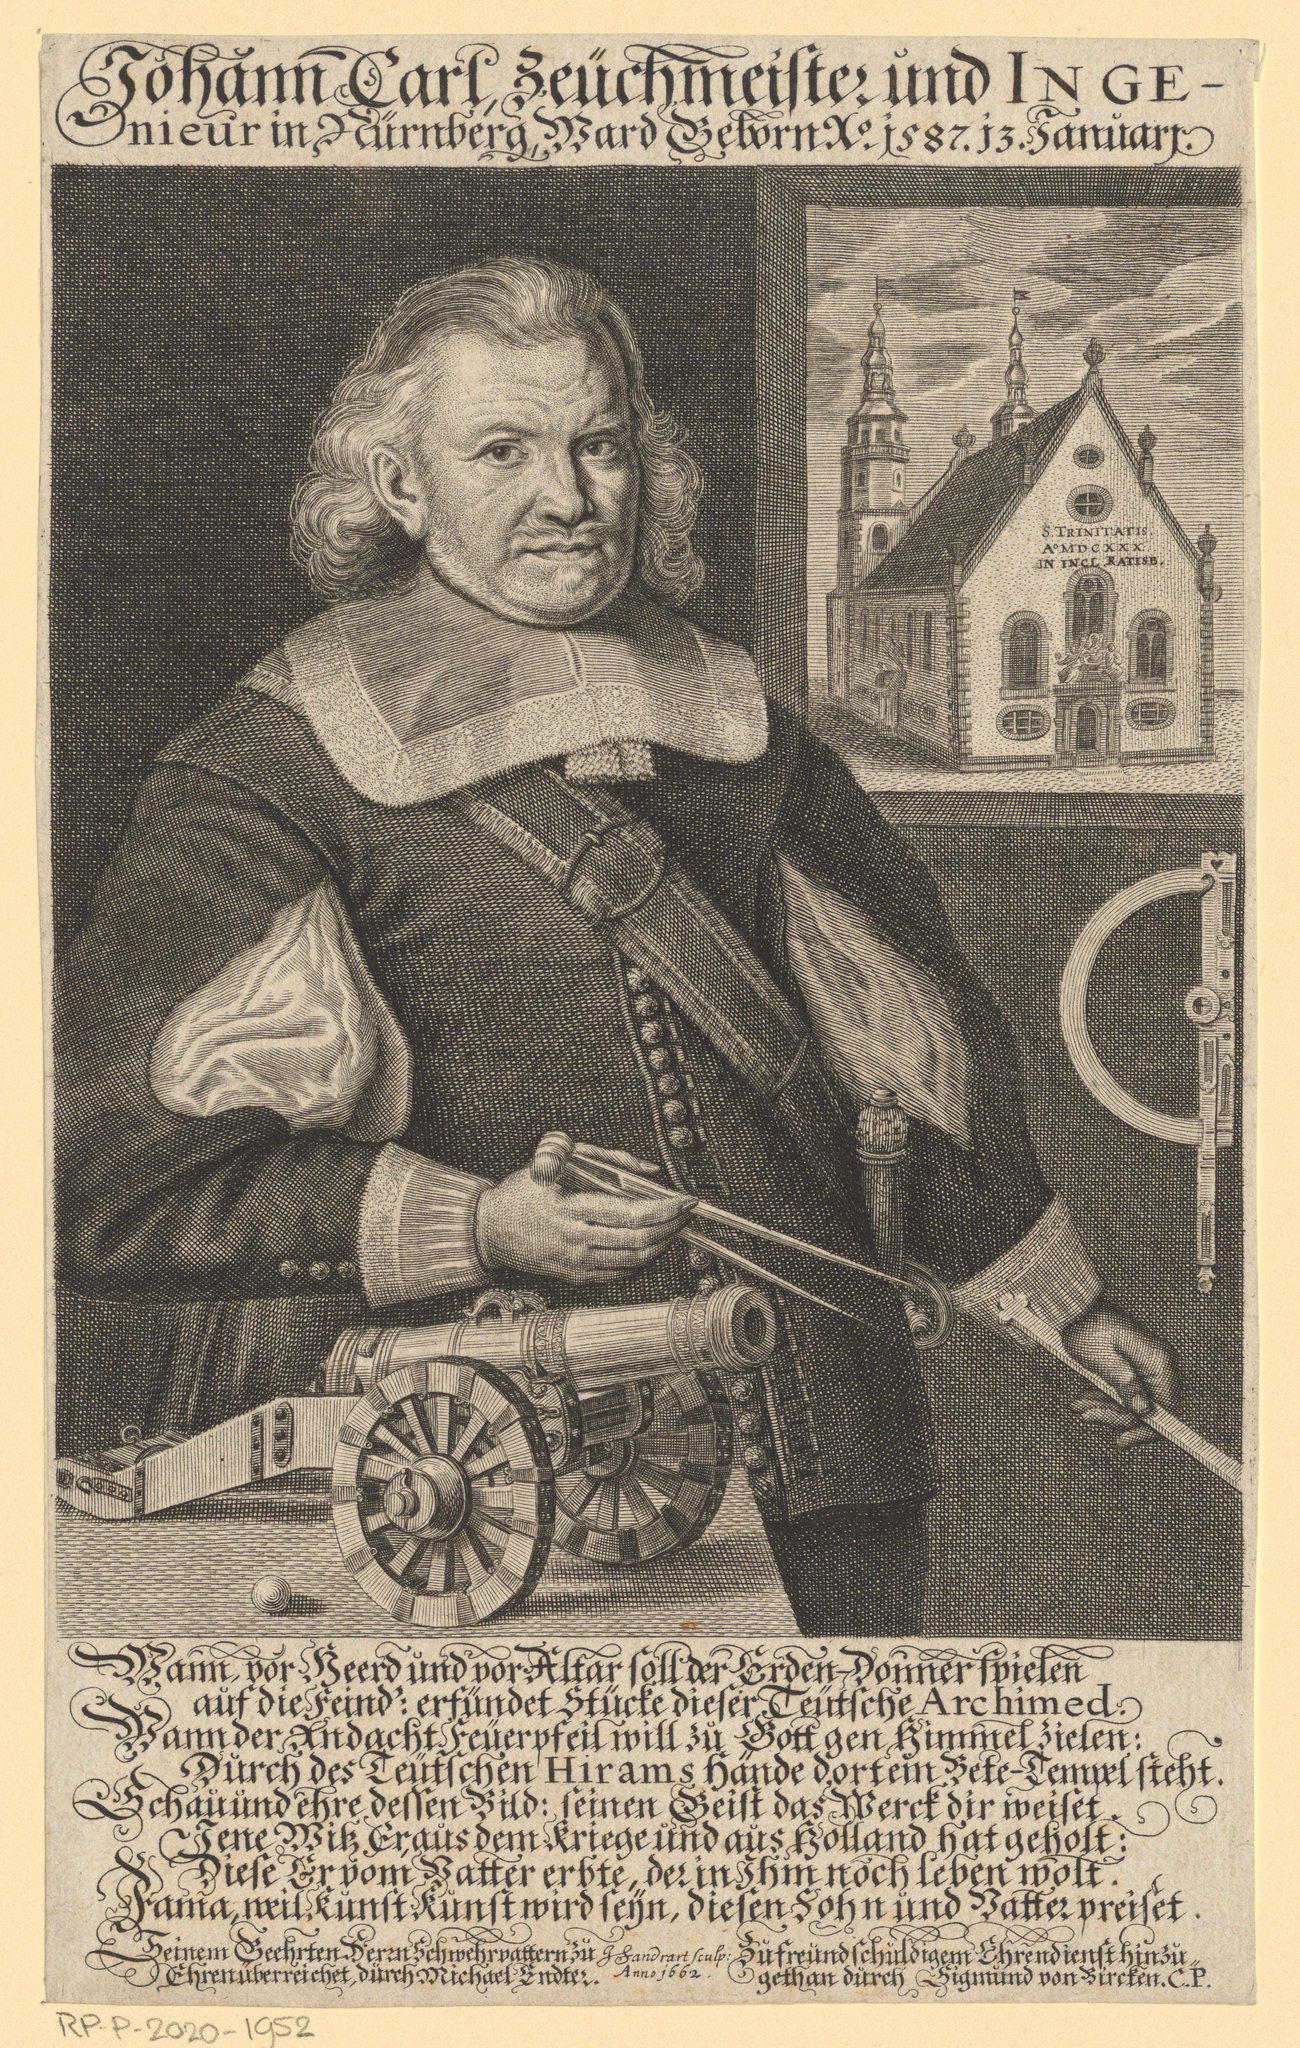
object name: print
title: Portret van Johann Carl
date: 1662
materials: paper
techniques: engraving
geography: nuremberg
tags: engineer, historical persons, portrait, self-portrait of architect, firearms: cannon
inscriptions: date